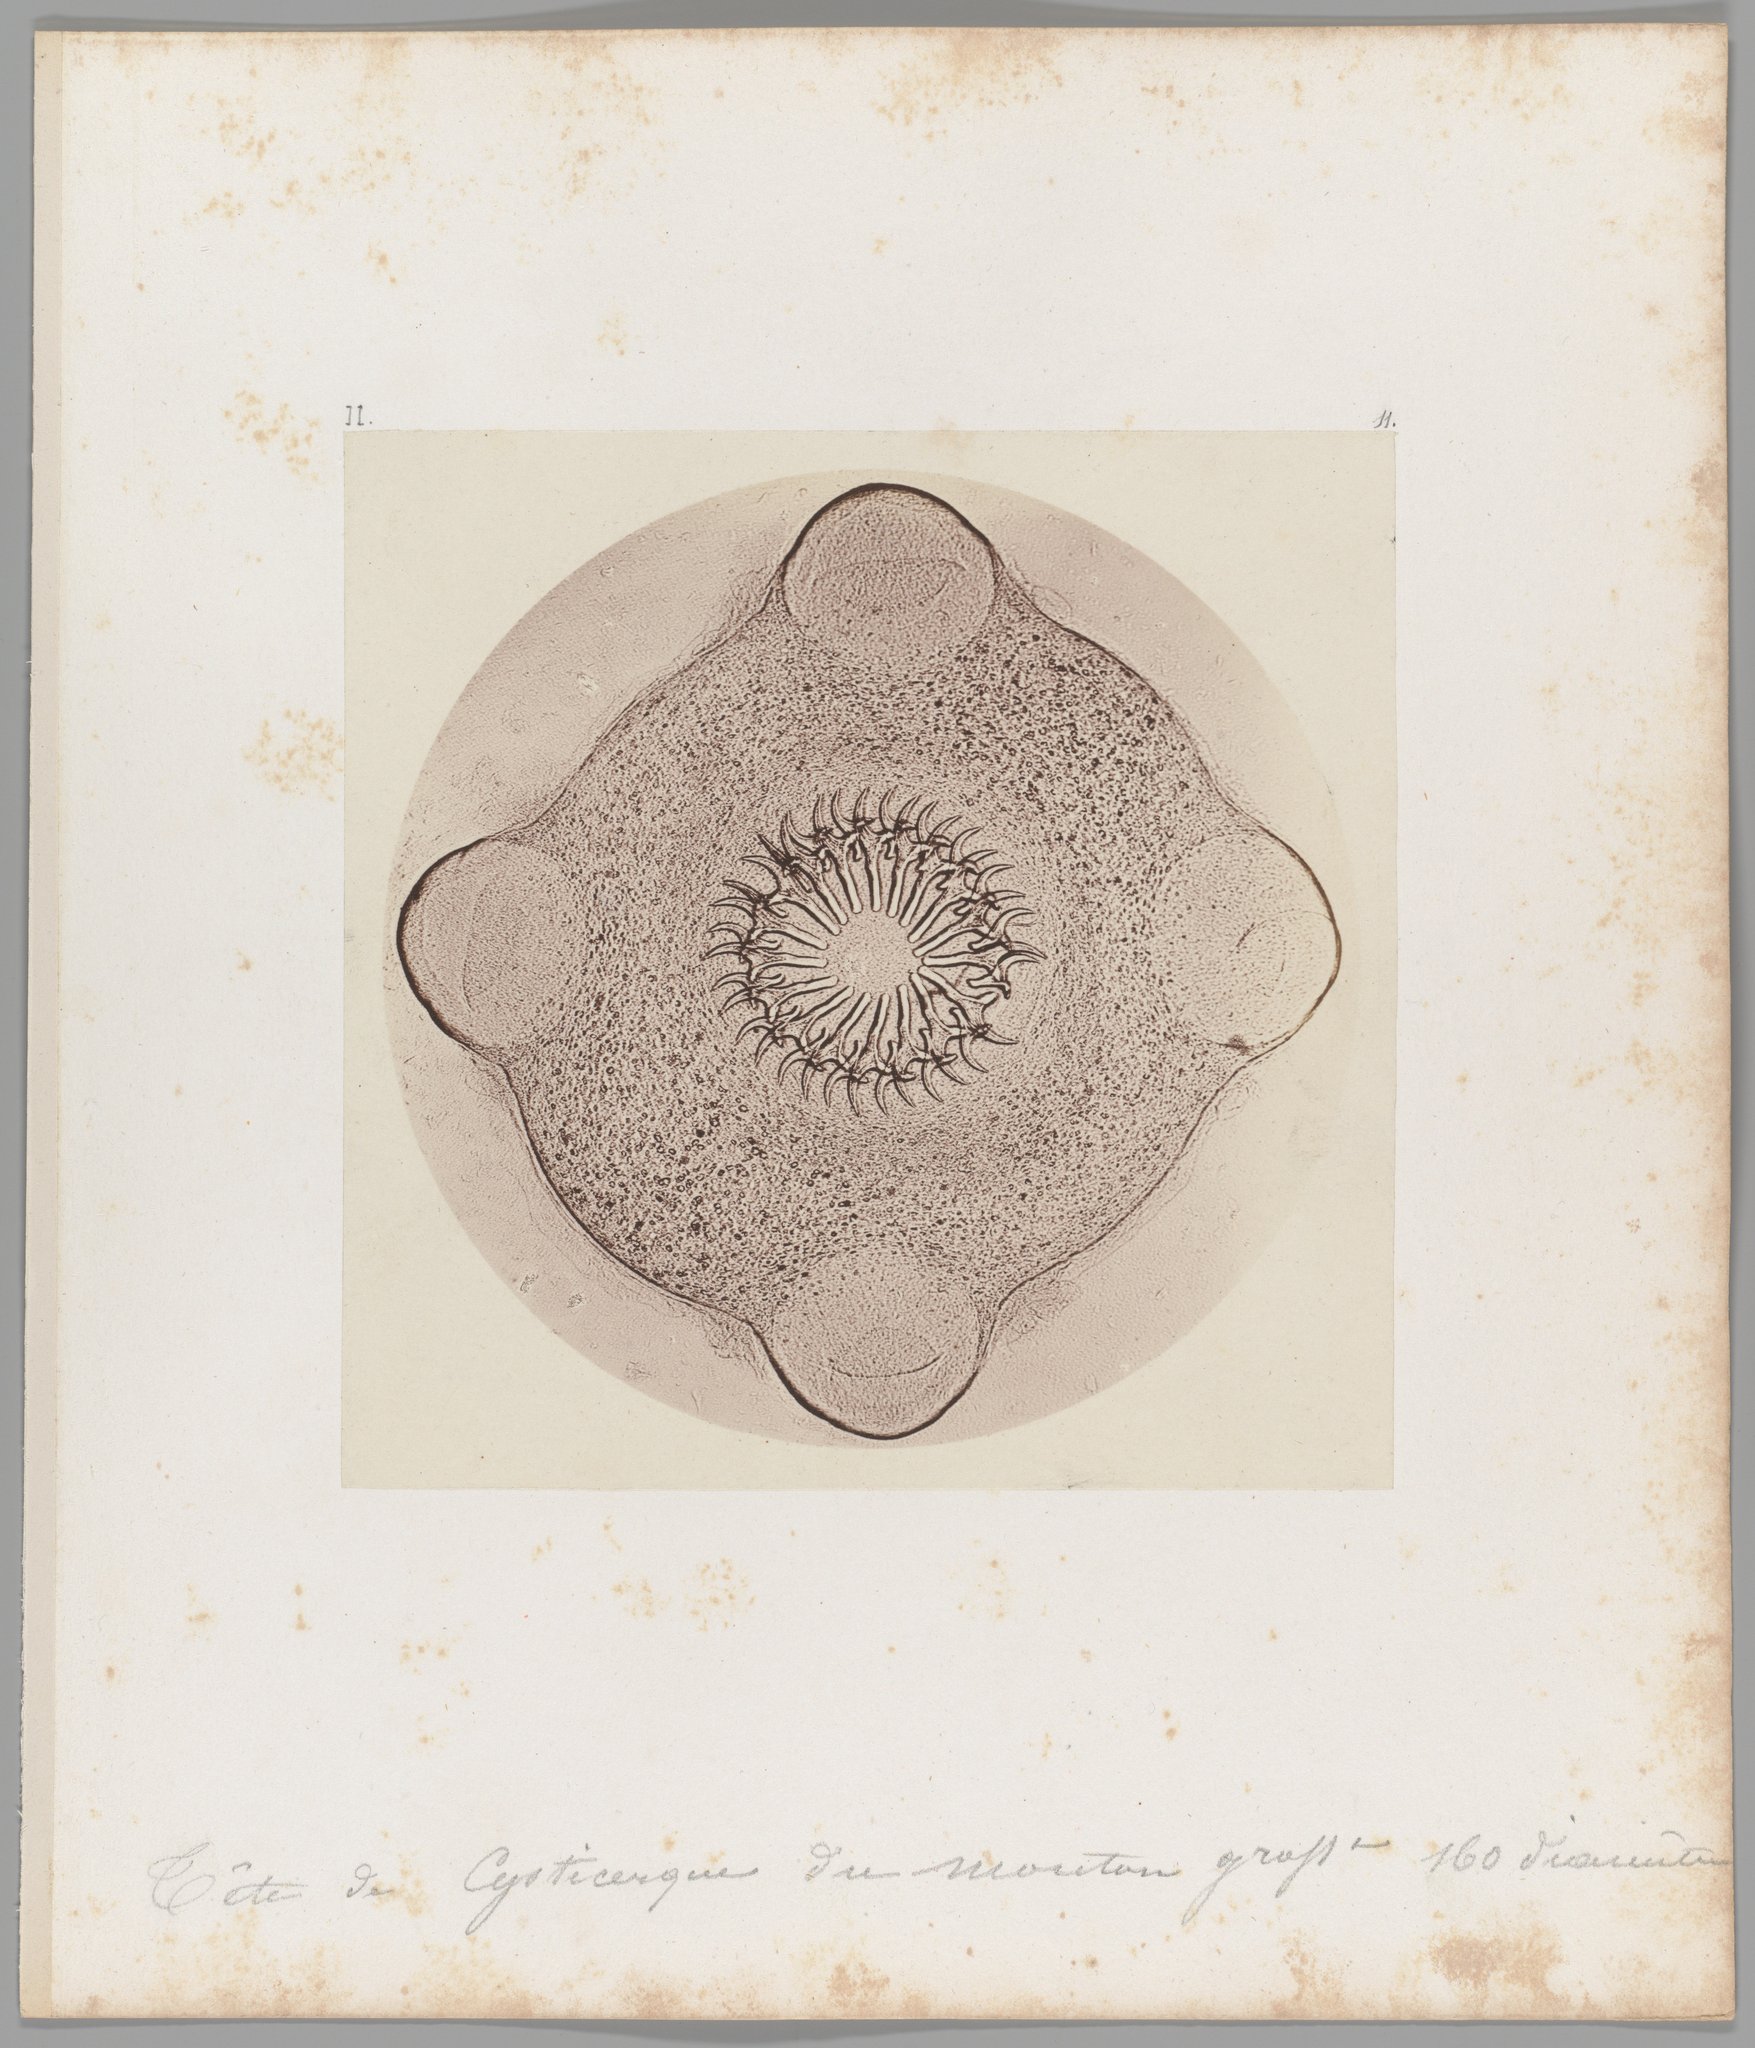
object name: photograph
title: [Untitled]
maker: auguste-adolphe bertsch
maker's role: artist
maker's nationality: french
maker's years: 1813-1871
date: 1853-1857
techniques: salted paper print